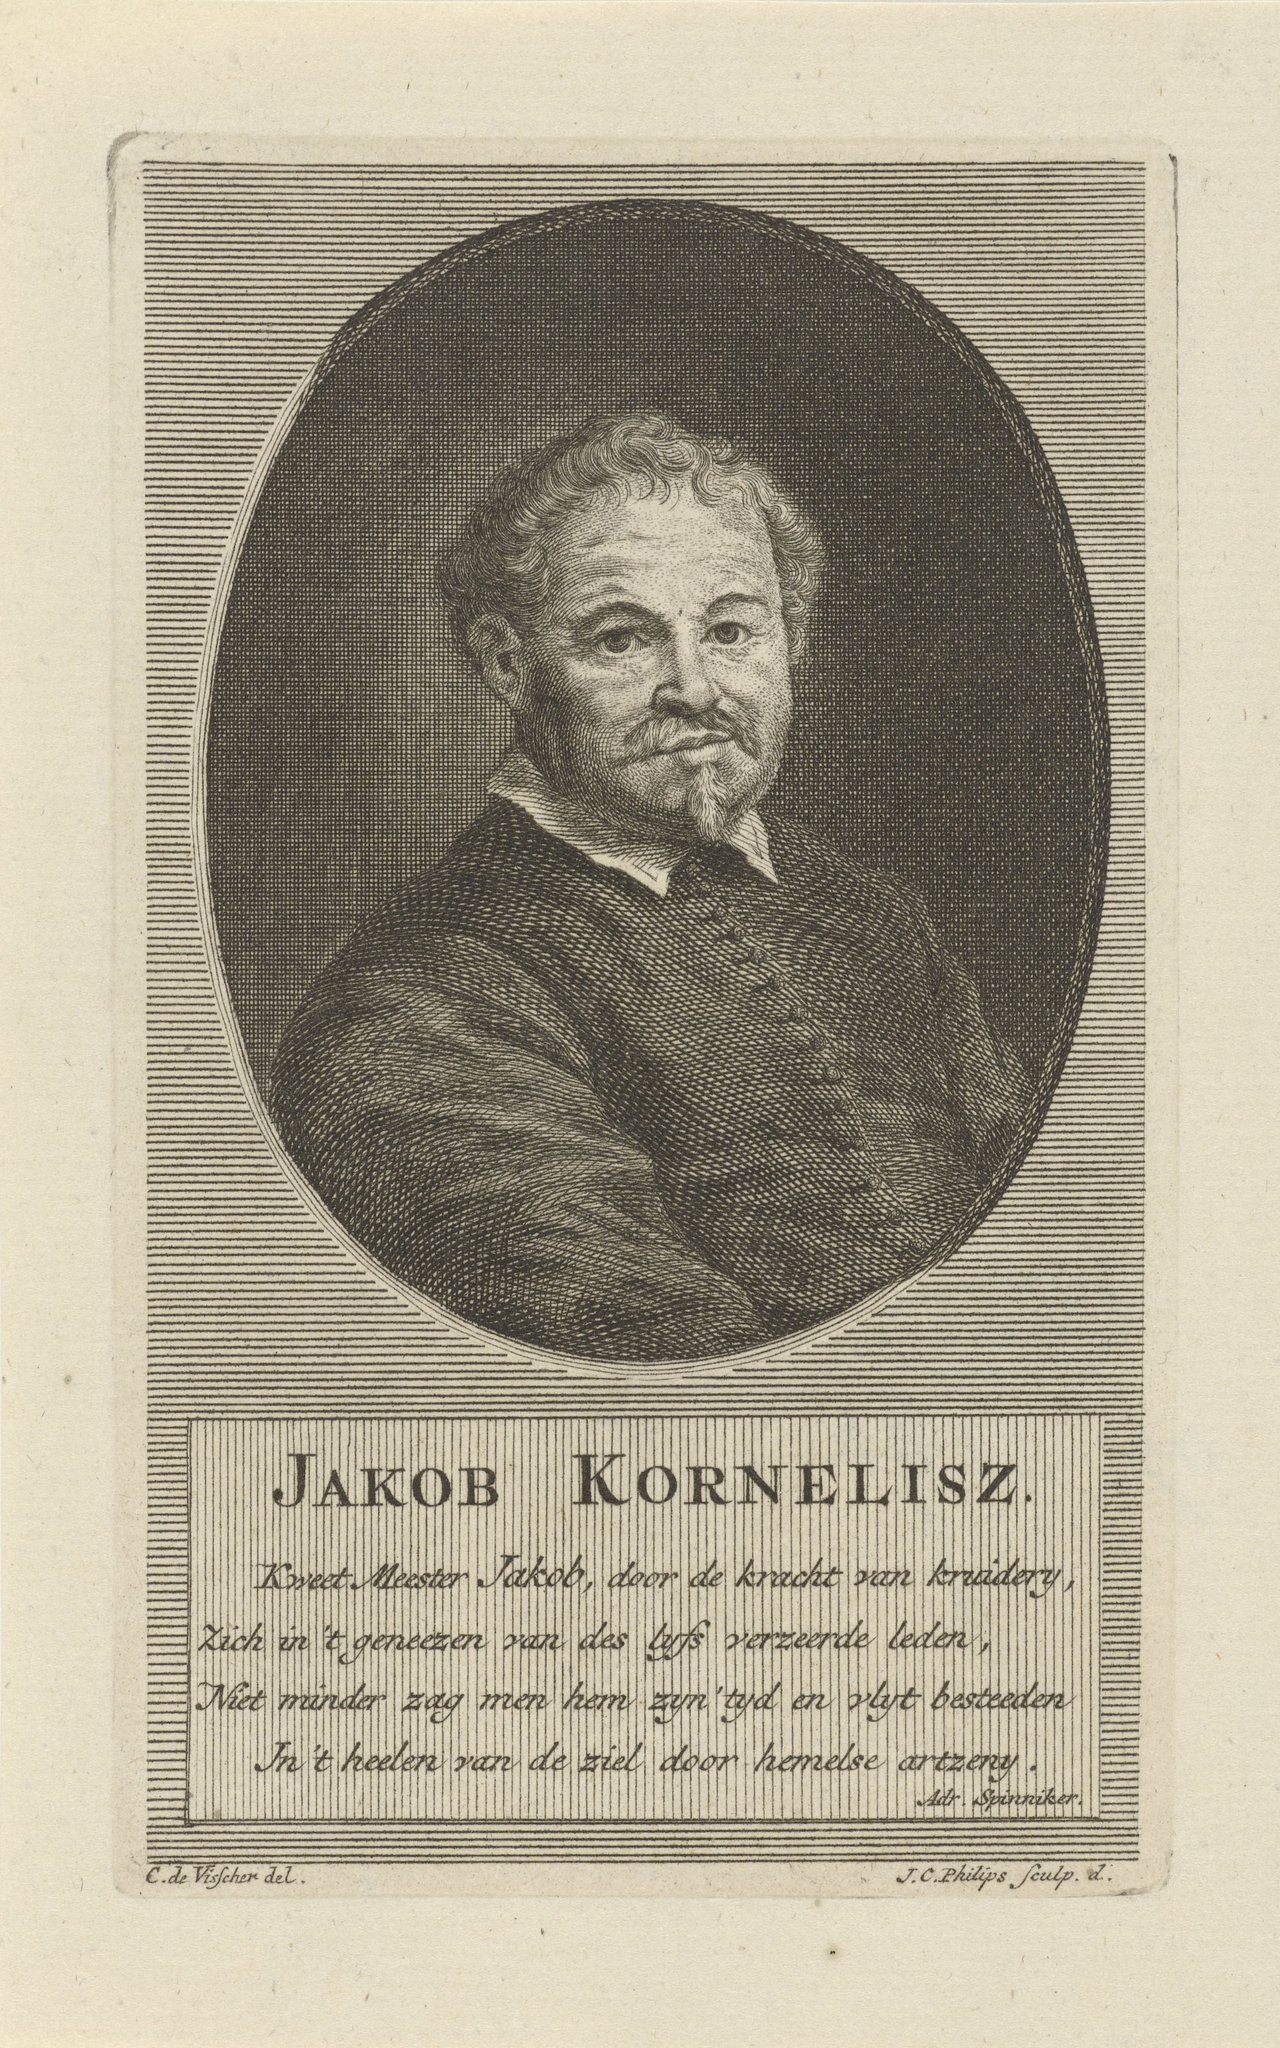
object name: print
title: Portret van de doopsgezinde predikant Jacob Cornelisz.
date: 1736-1775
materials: paper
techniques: engraving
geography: amsterdam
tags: amsterdam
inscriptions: collector's mark: Lugt 2228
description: Portret van Jacob Cornelisz., doopsgezinde predikant en chirurgijn te Amsterdam. In het kader een vierregelig lofdicht in het Nederlands.